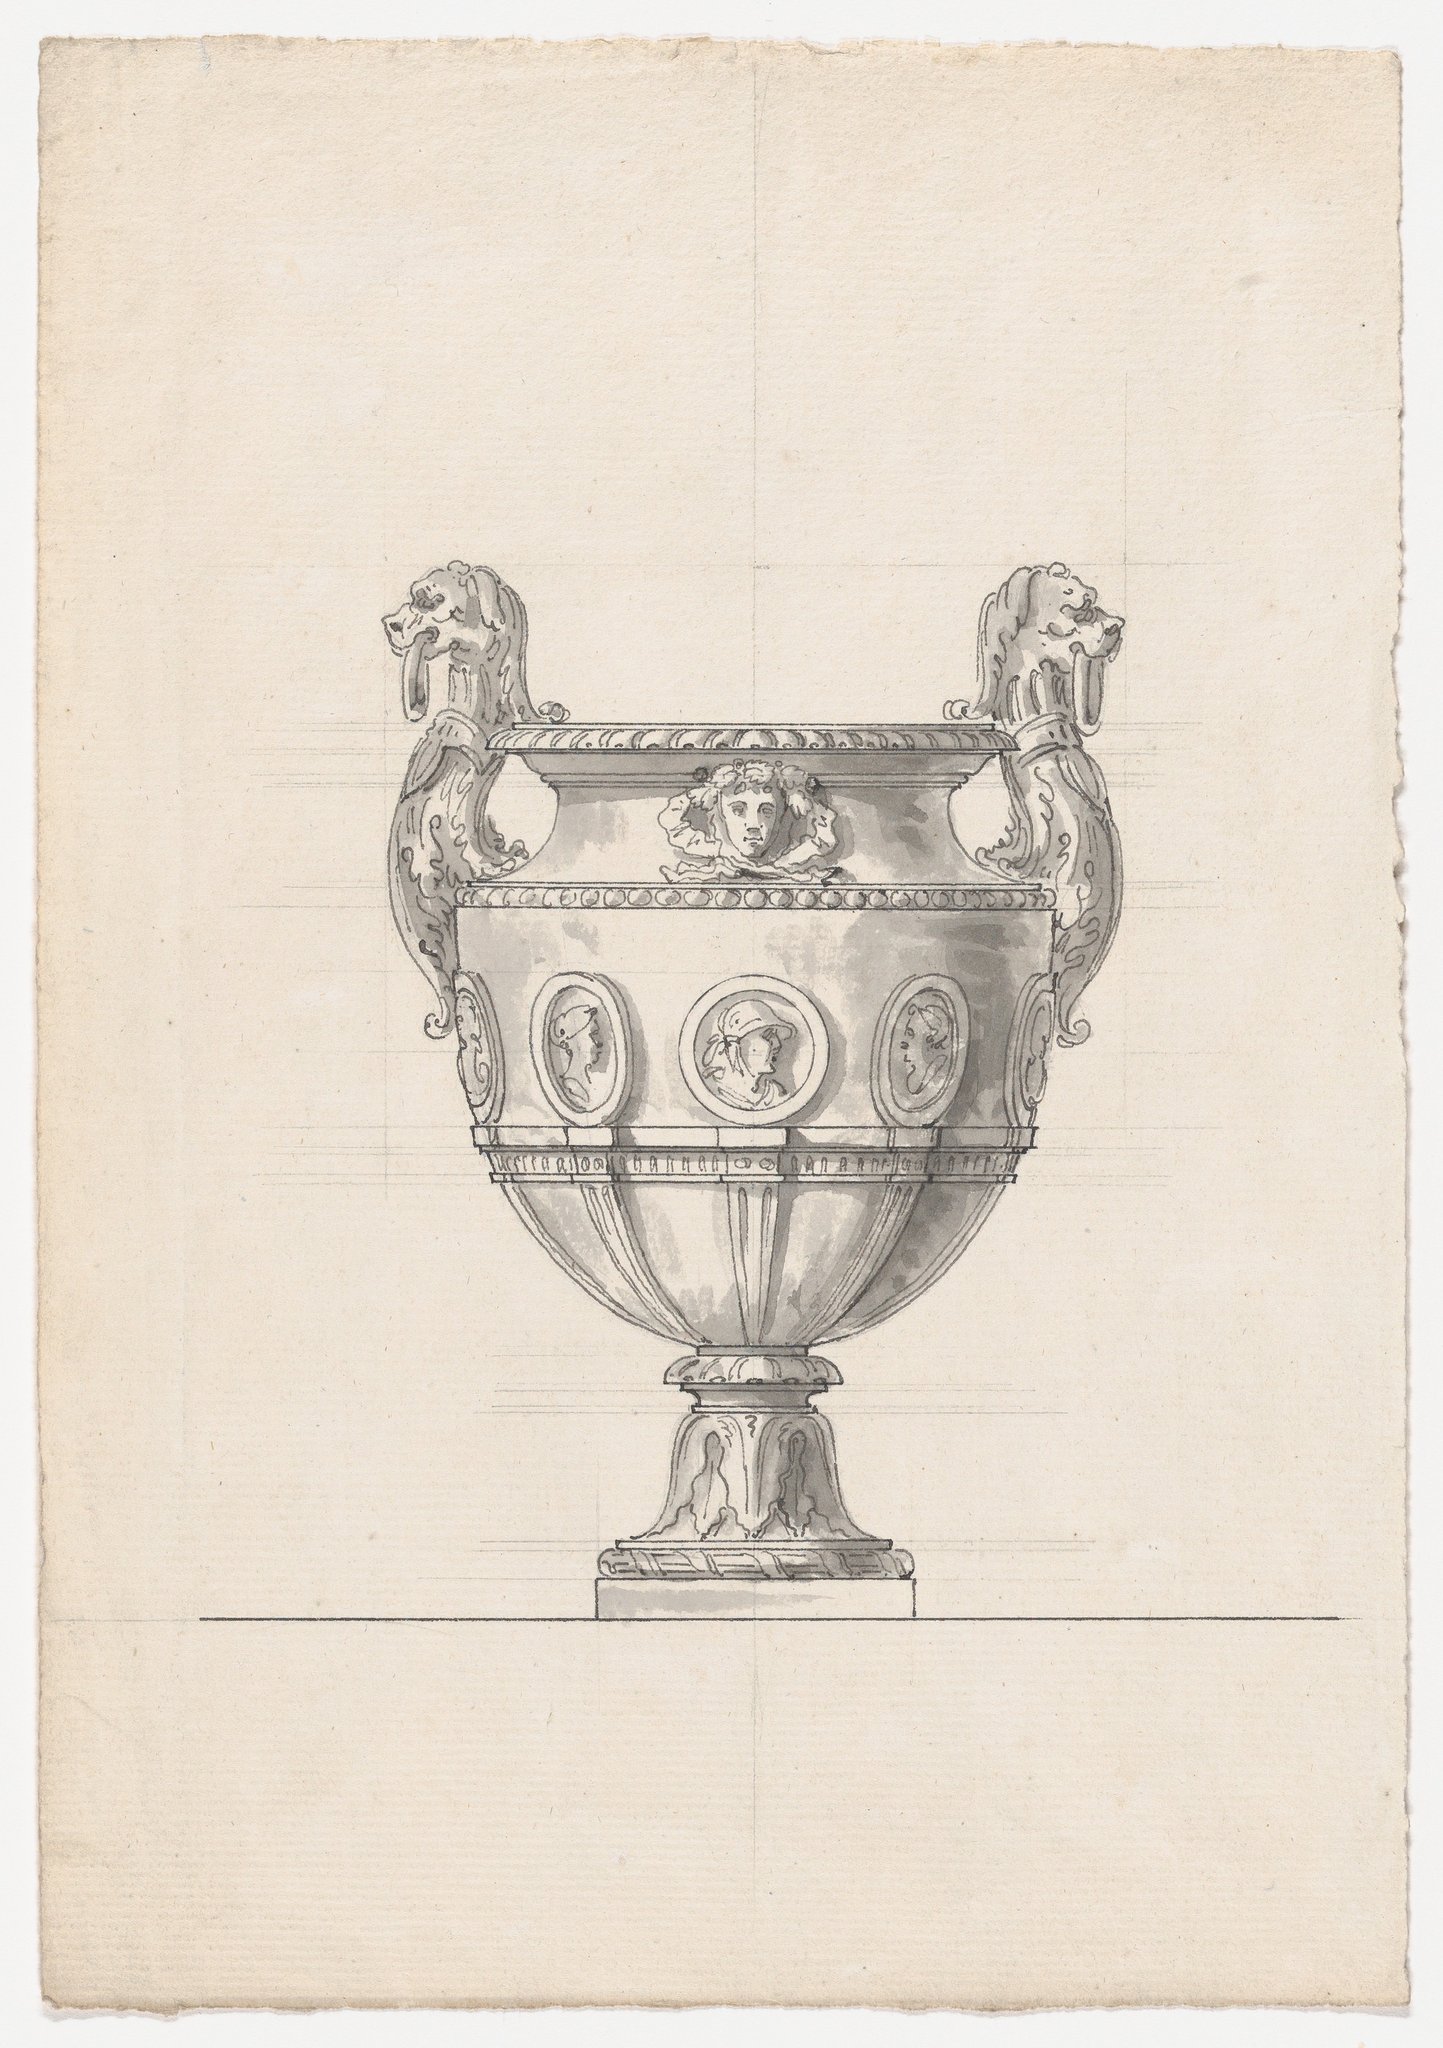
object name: drawing ornament architecture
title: Bronze Garden Vase with Portrait Medallions and Hybrid Lion-shaped Handles, possibly related to the Gardens of Versailles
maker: claude ballin the elder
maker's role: artist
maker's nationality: french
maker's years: 1615-1678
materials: graphite, ink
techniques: pen, wash